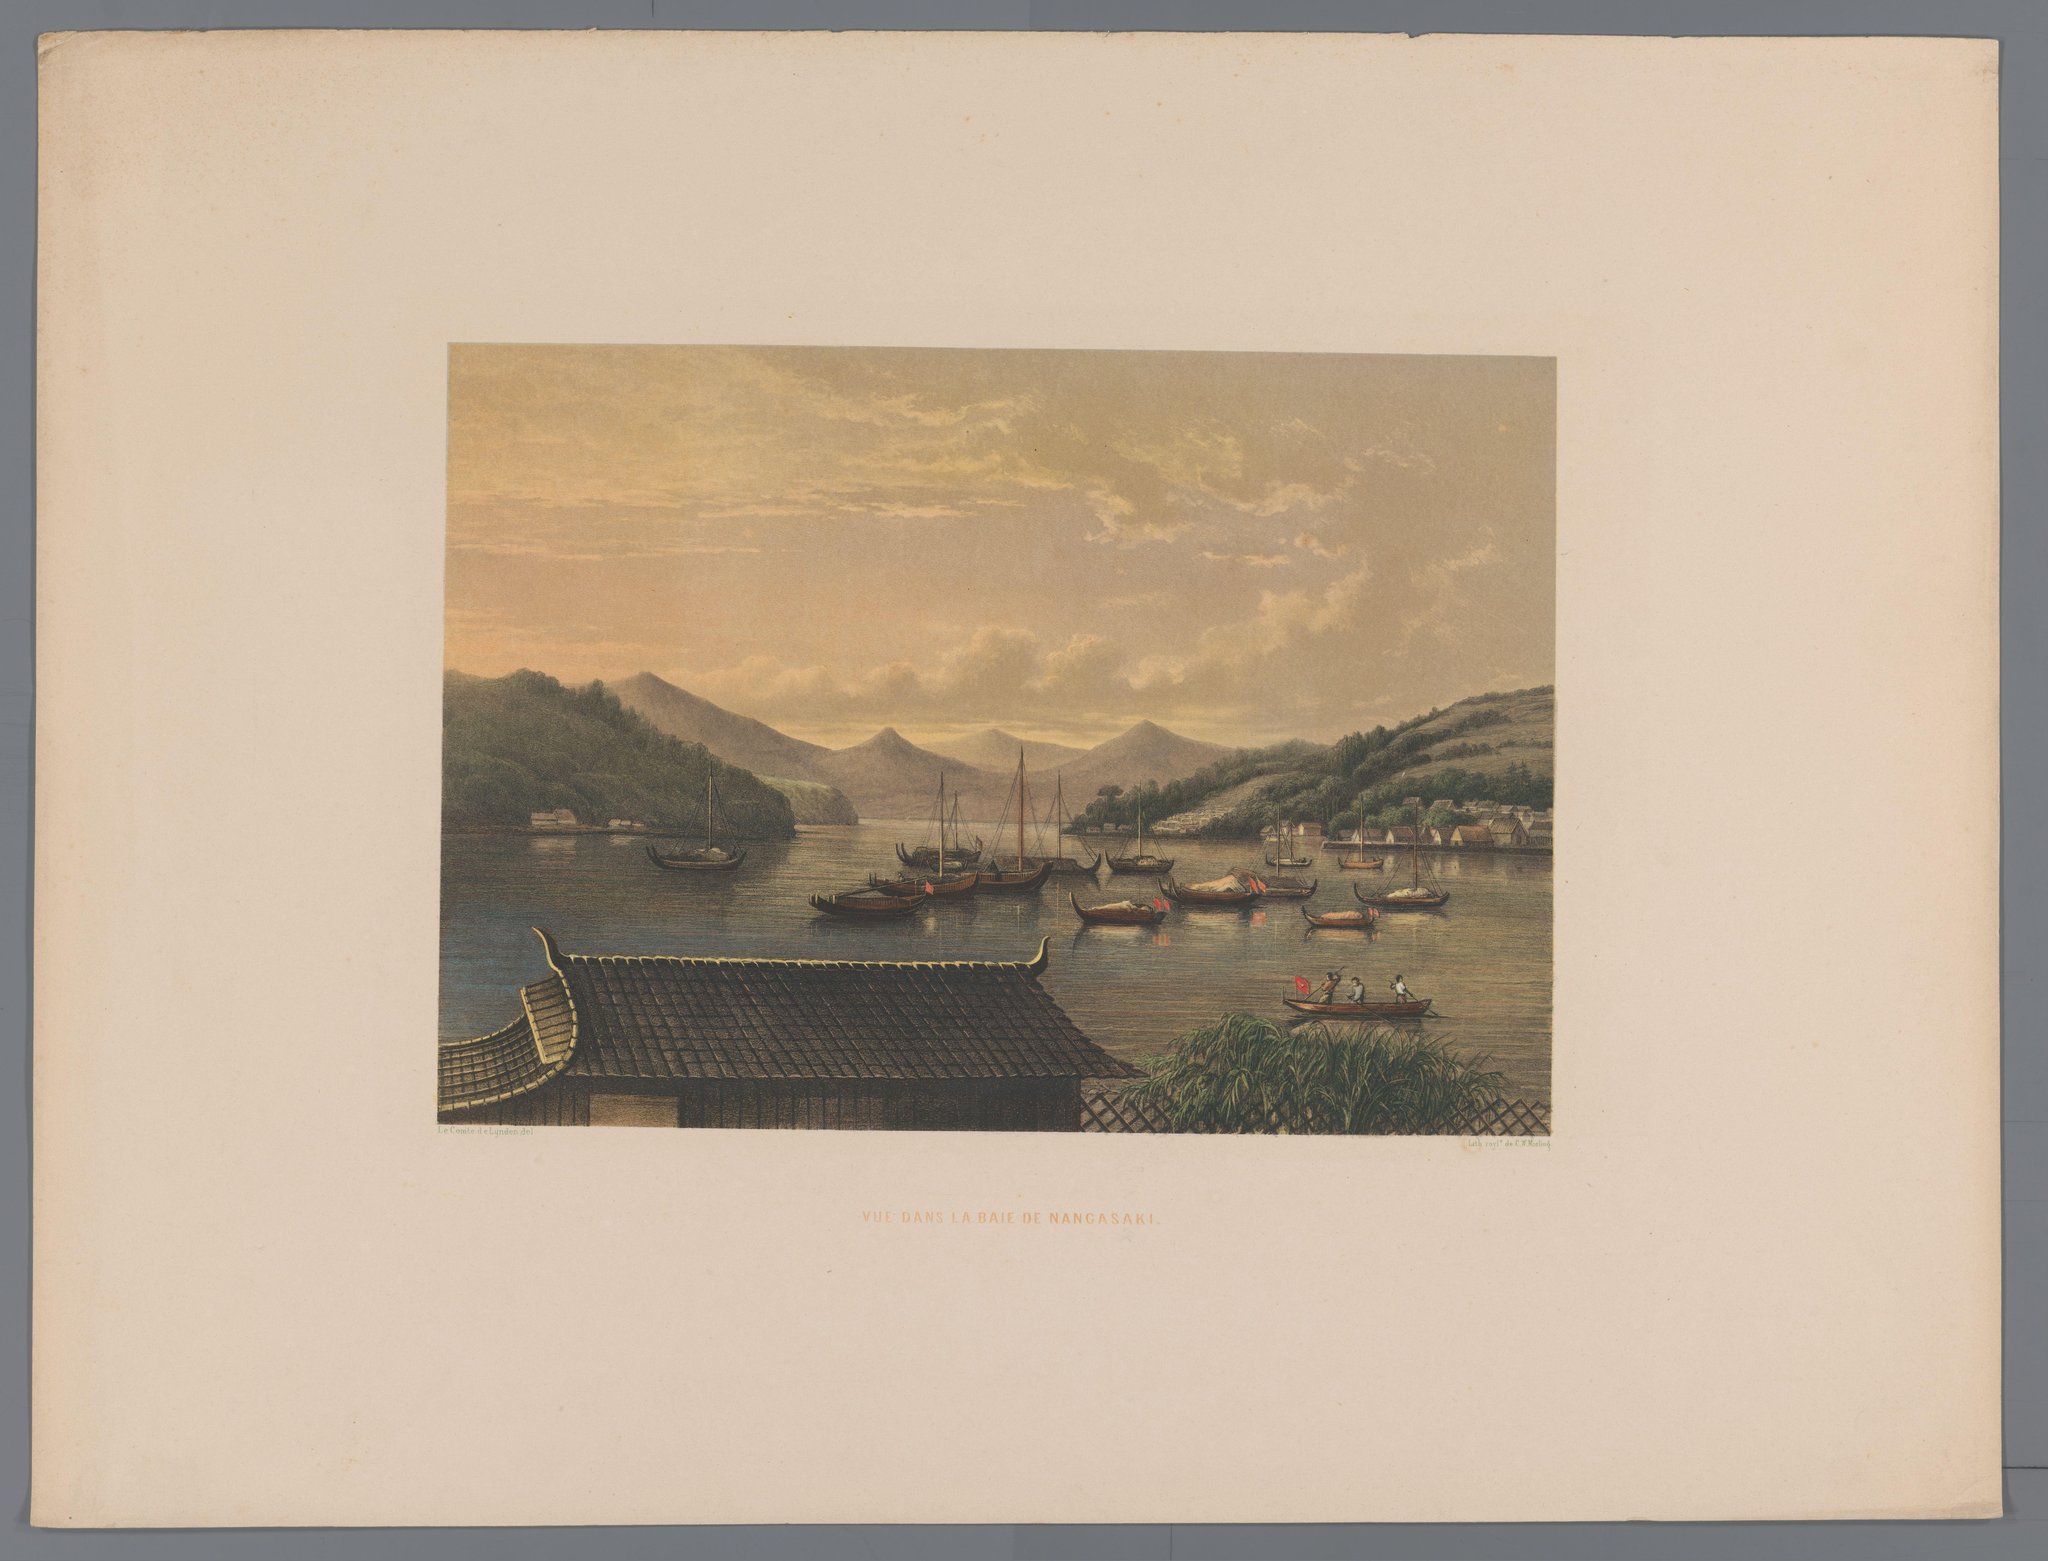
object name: print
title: Gezicht op de baai van Nagasaki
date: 1862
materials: paper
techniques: chromolithography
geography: the hague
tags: gulf, bay, sailing-ship, sailing-boat